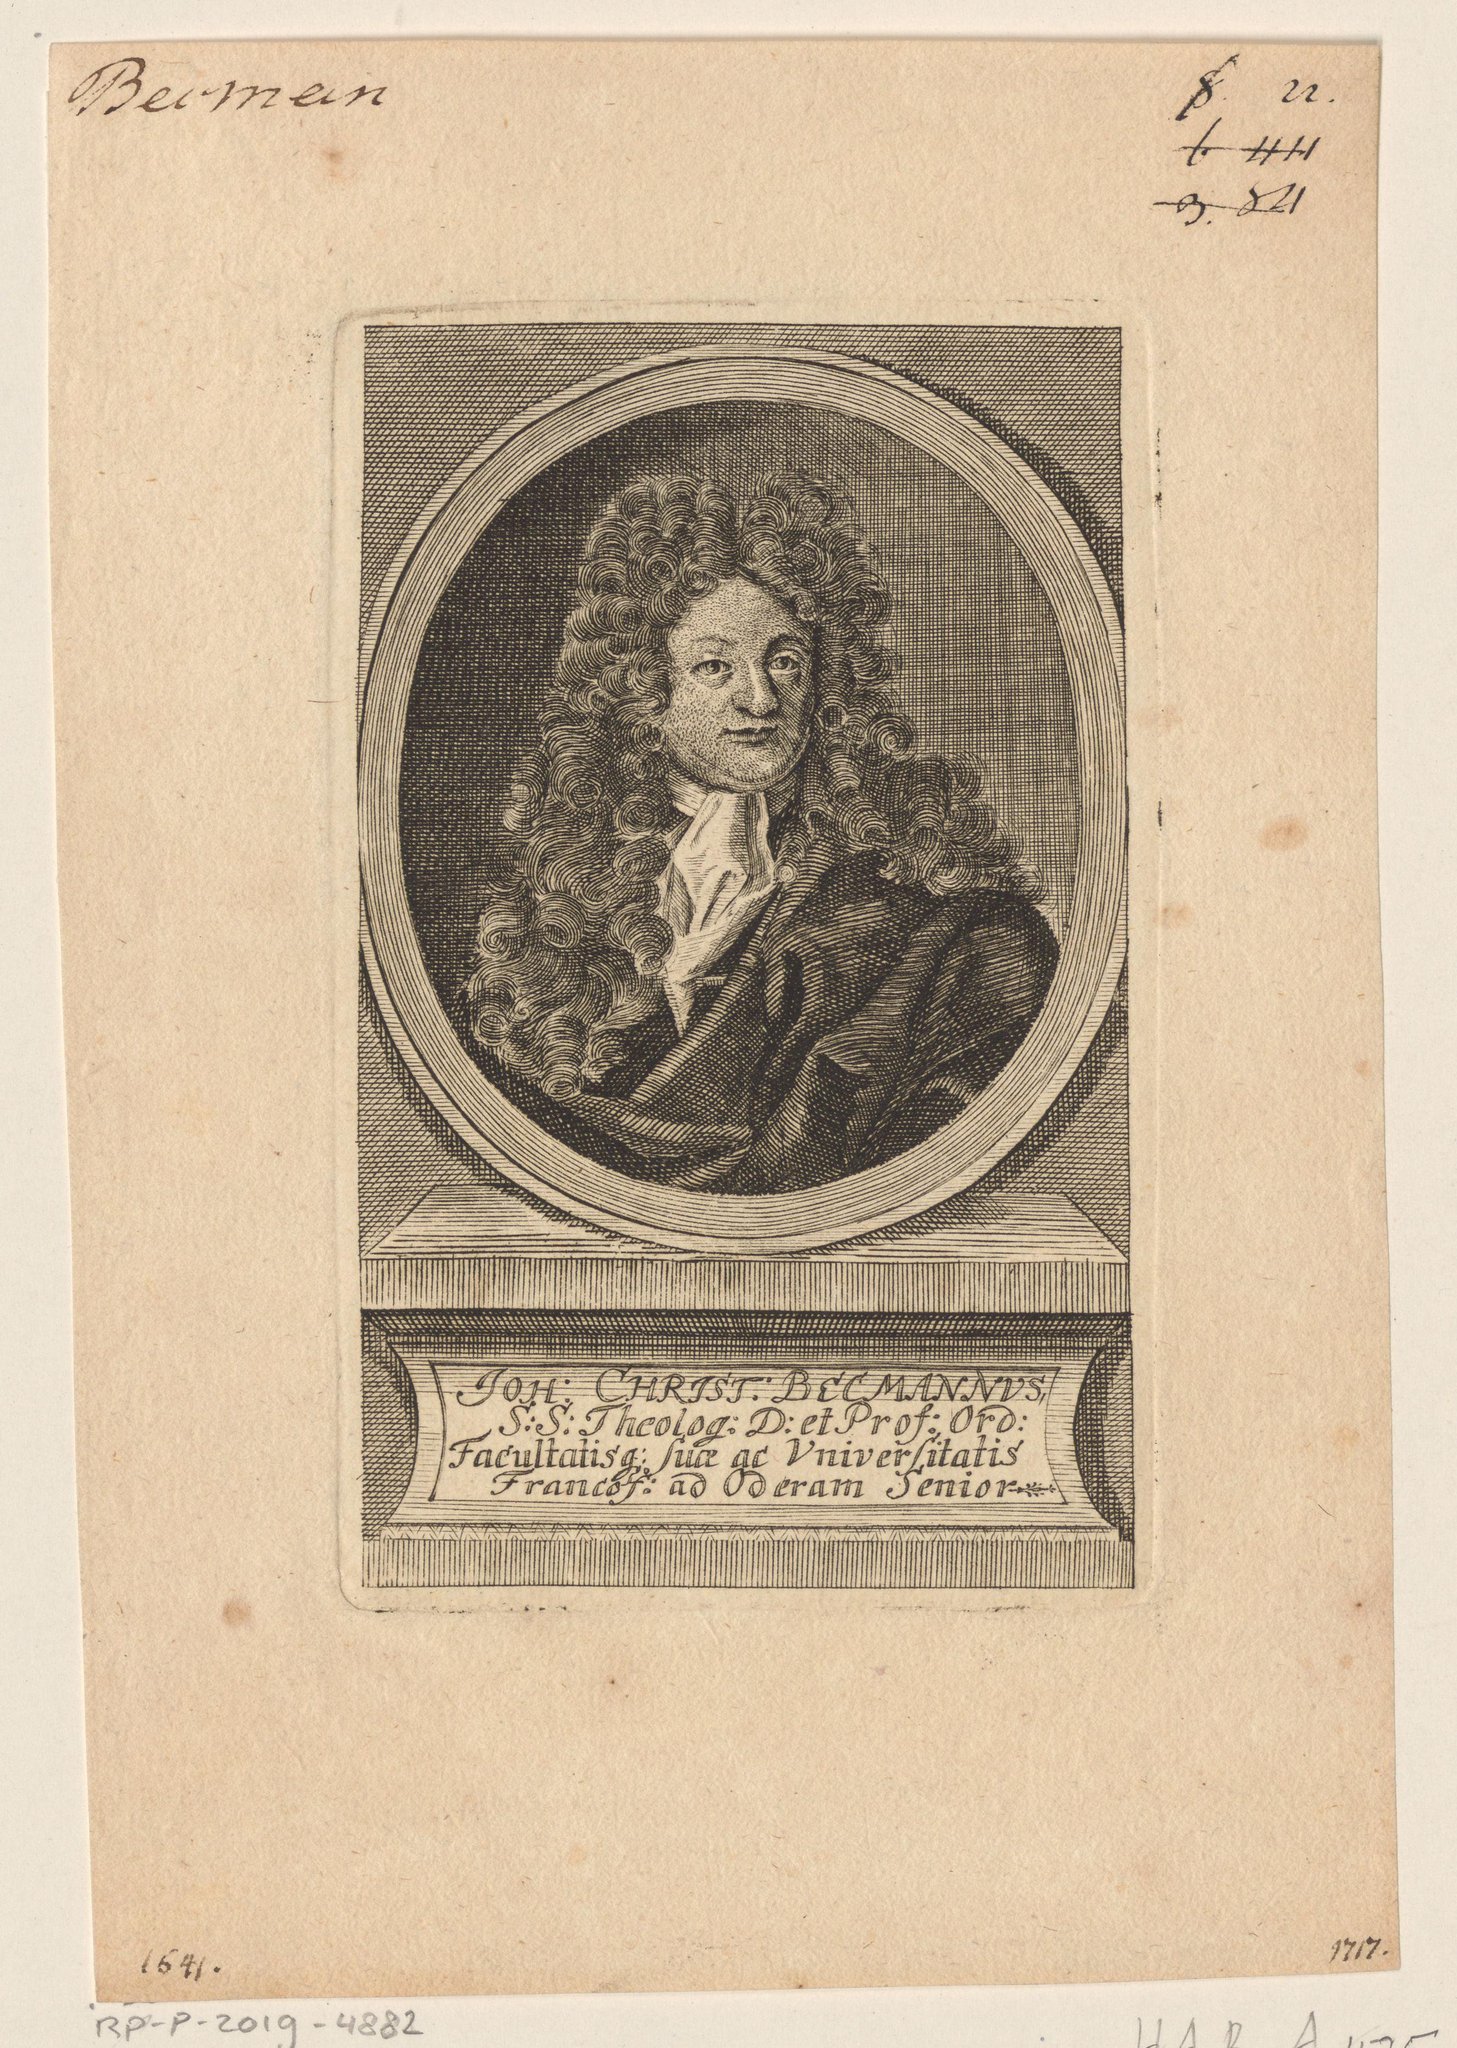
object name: print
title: Portret van Johann Christoph Becmann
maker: Anonymous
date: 1710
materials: paper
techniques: engraving, etching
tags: historical persons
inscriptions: inscription: ‘Becmen [...]’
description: Andere staat van de prent verschenen in: Neue Bibliothec oder Nachricht und Urtheile von neuen Büchern (...). Frankfurt am Main en Leipzig: Johann Gottfried Renger, 1710.